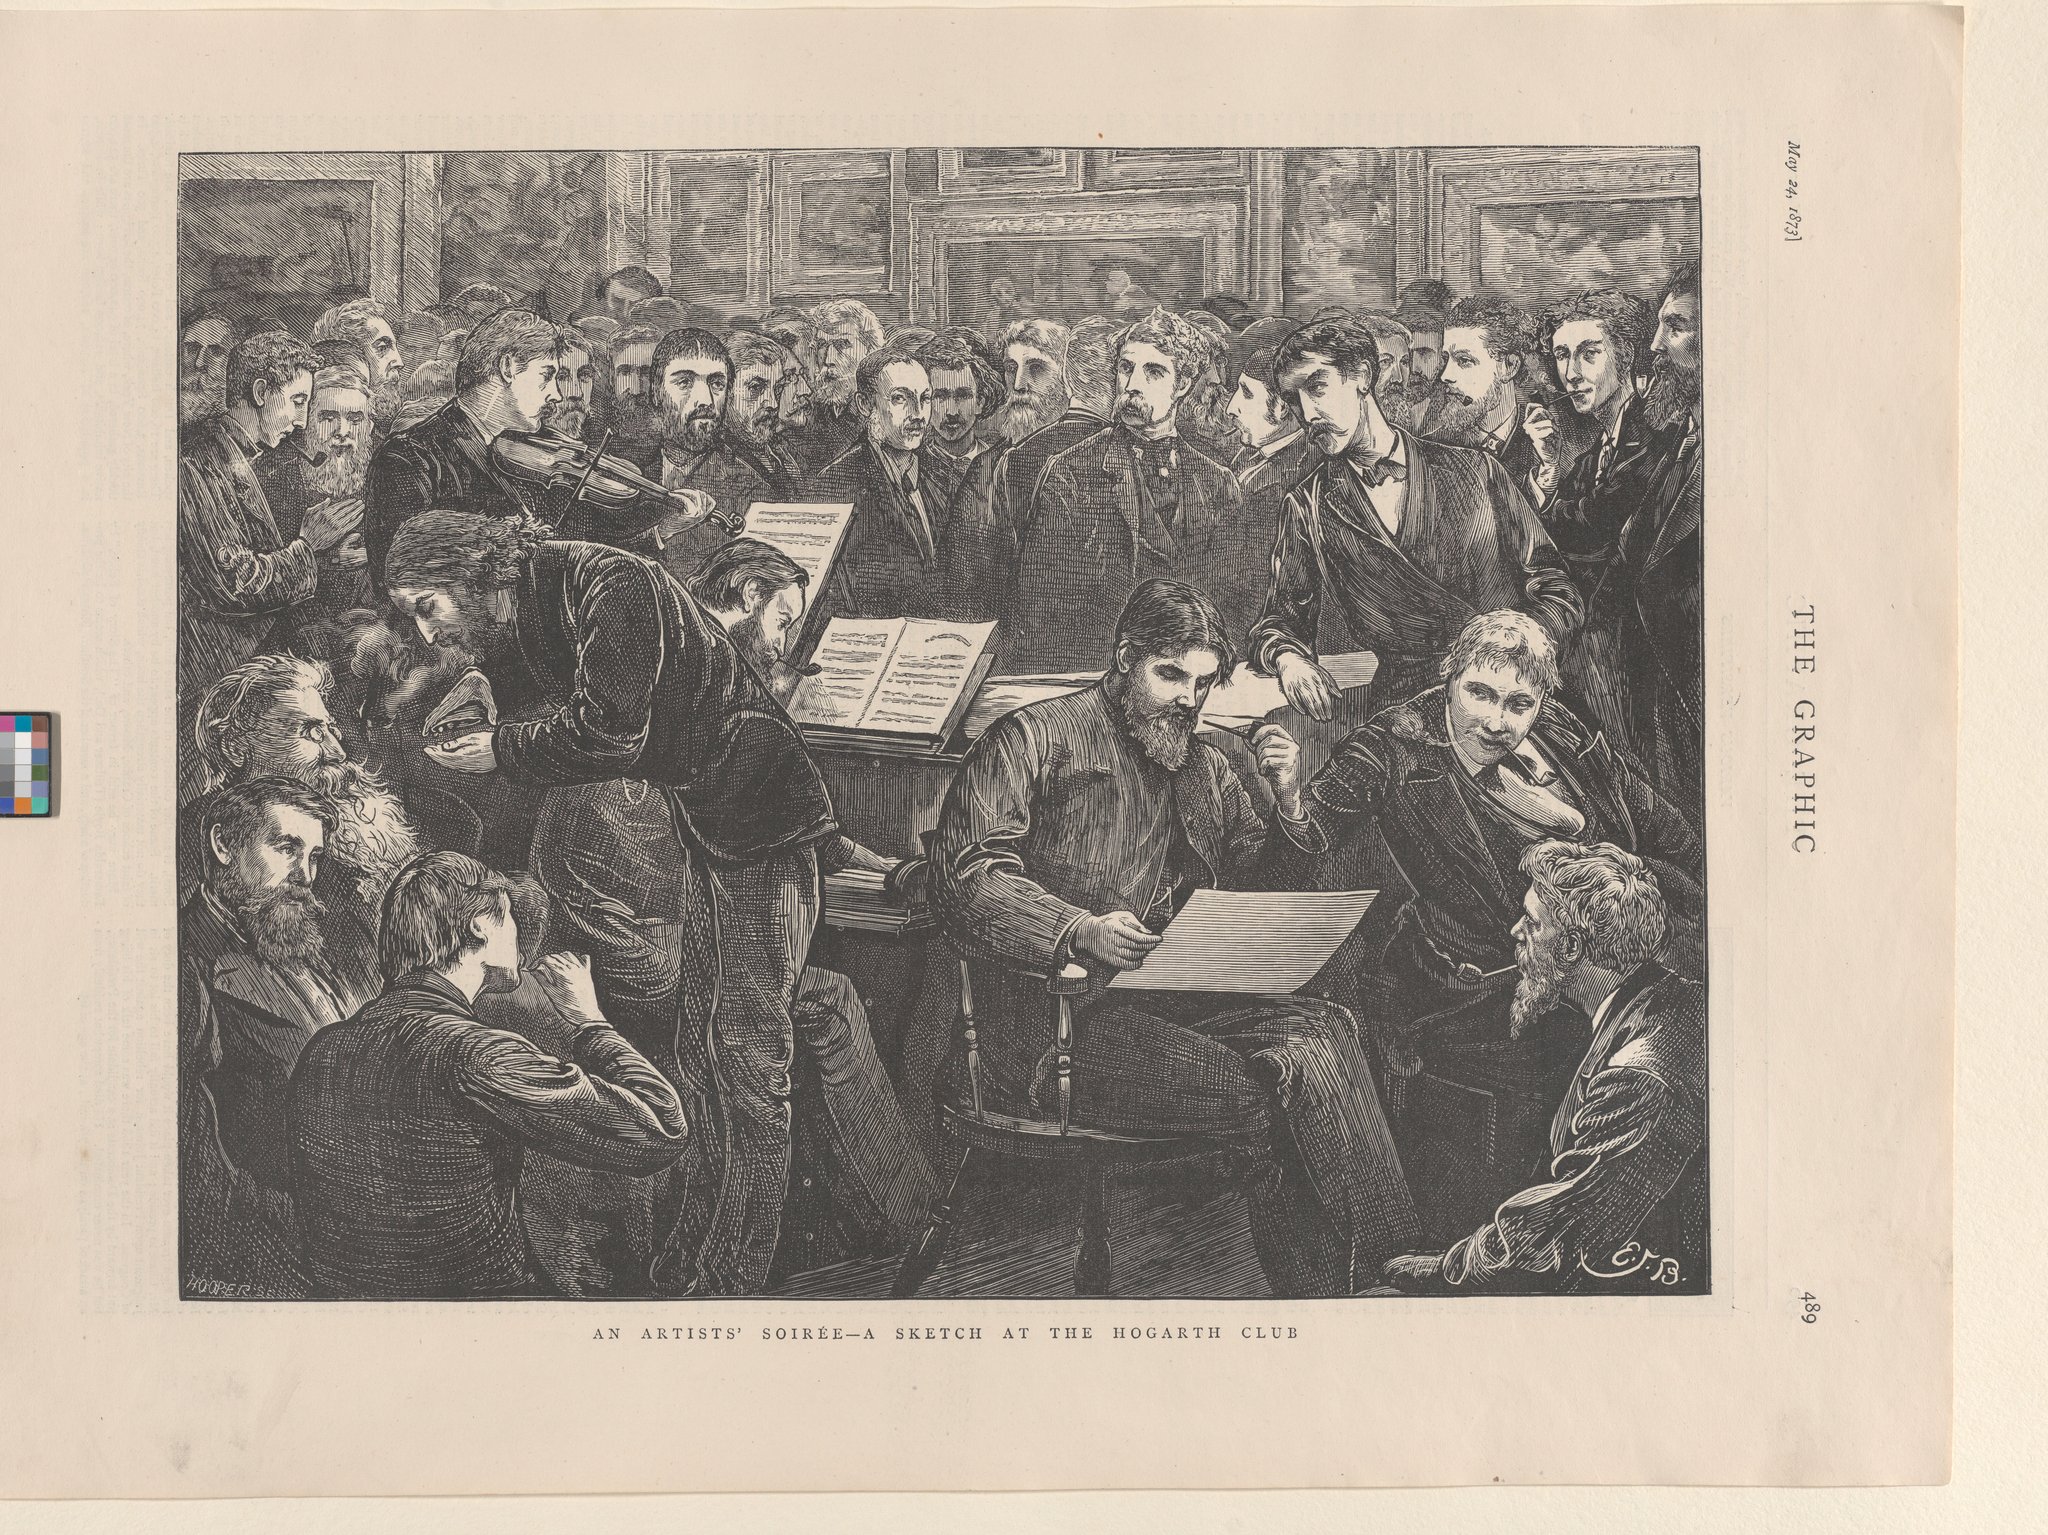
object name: print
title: An Artists' Soirée–A Sketch at the Hogarth Club, from "The Graphic," p. 489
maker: william harcourt hooper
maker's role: engraver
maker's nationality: british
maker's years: 1834-1912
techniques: engraving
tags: men,smoking,pianos,violins,pipes